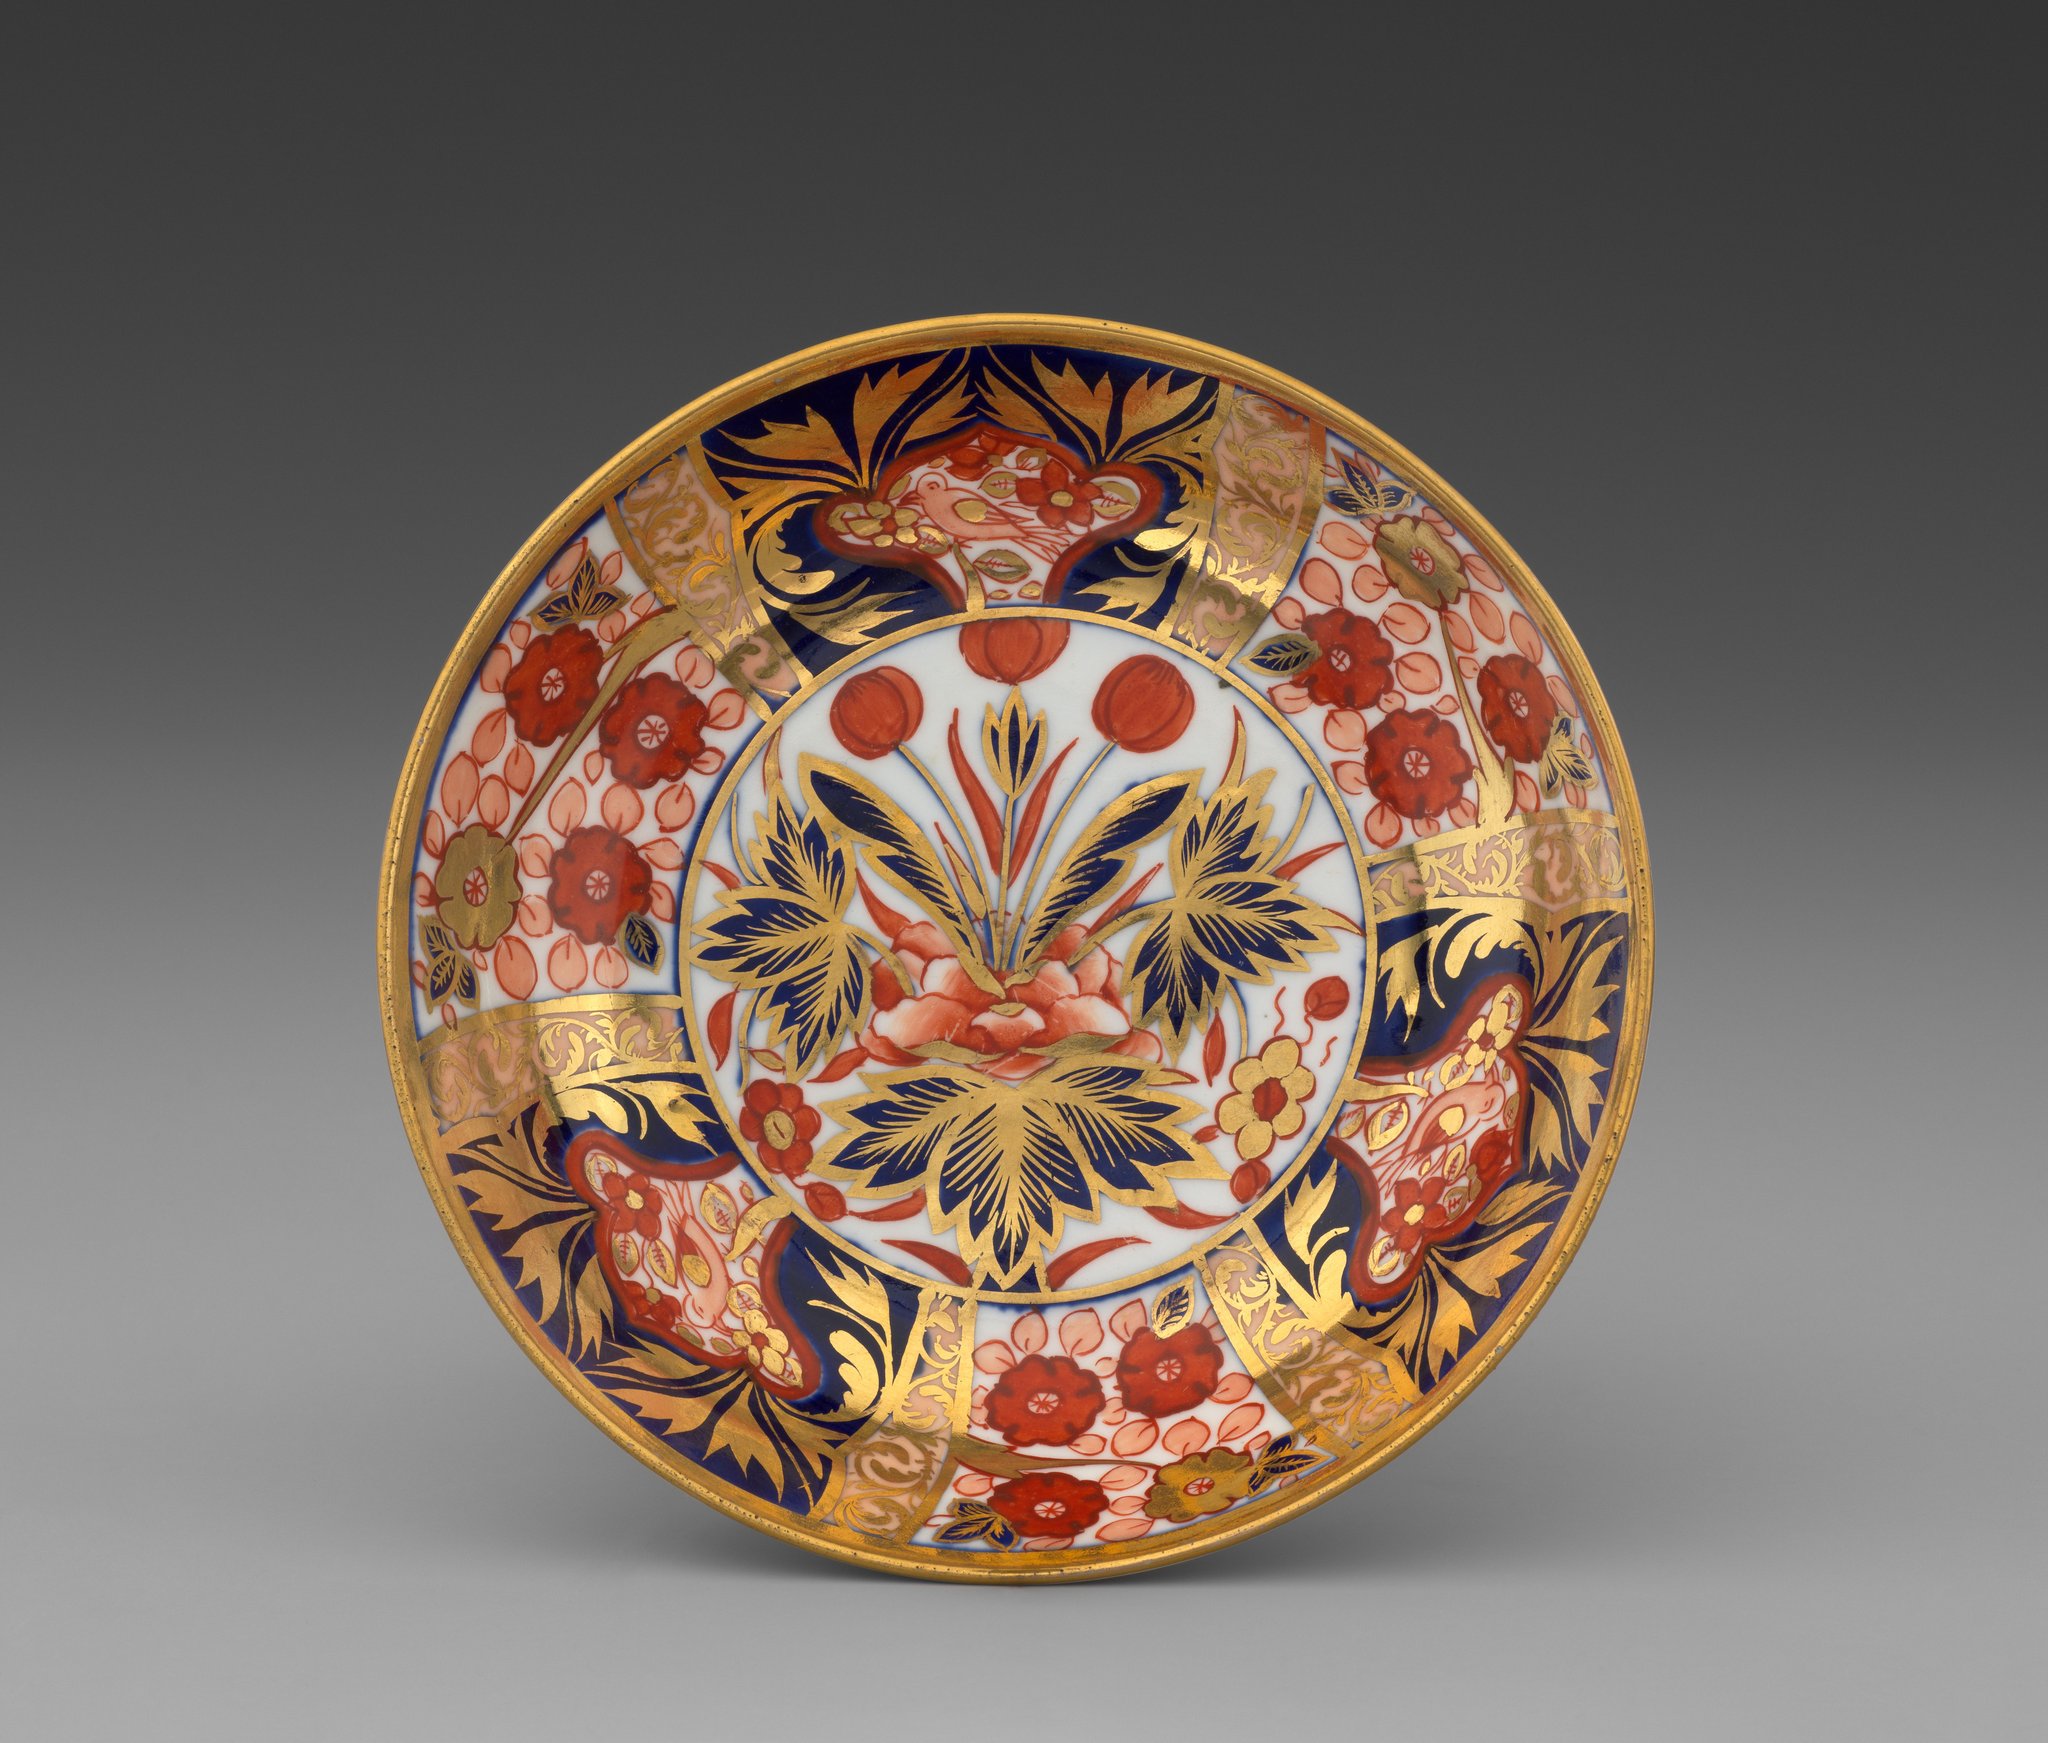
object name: saucer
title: Saucer (part of a service)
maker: j. spode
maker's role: factory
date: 1800-1830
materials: soft paste porcelain